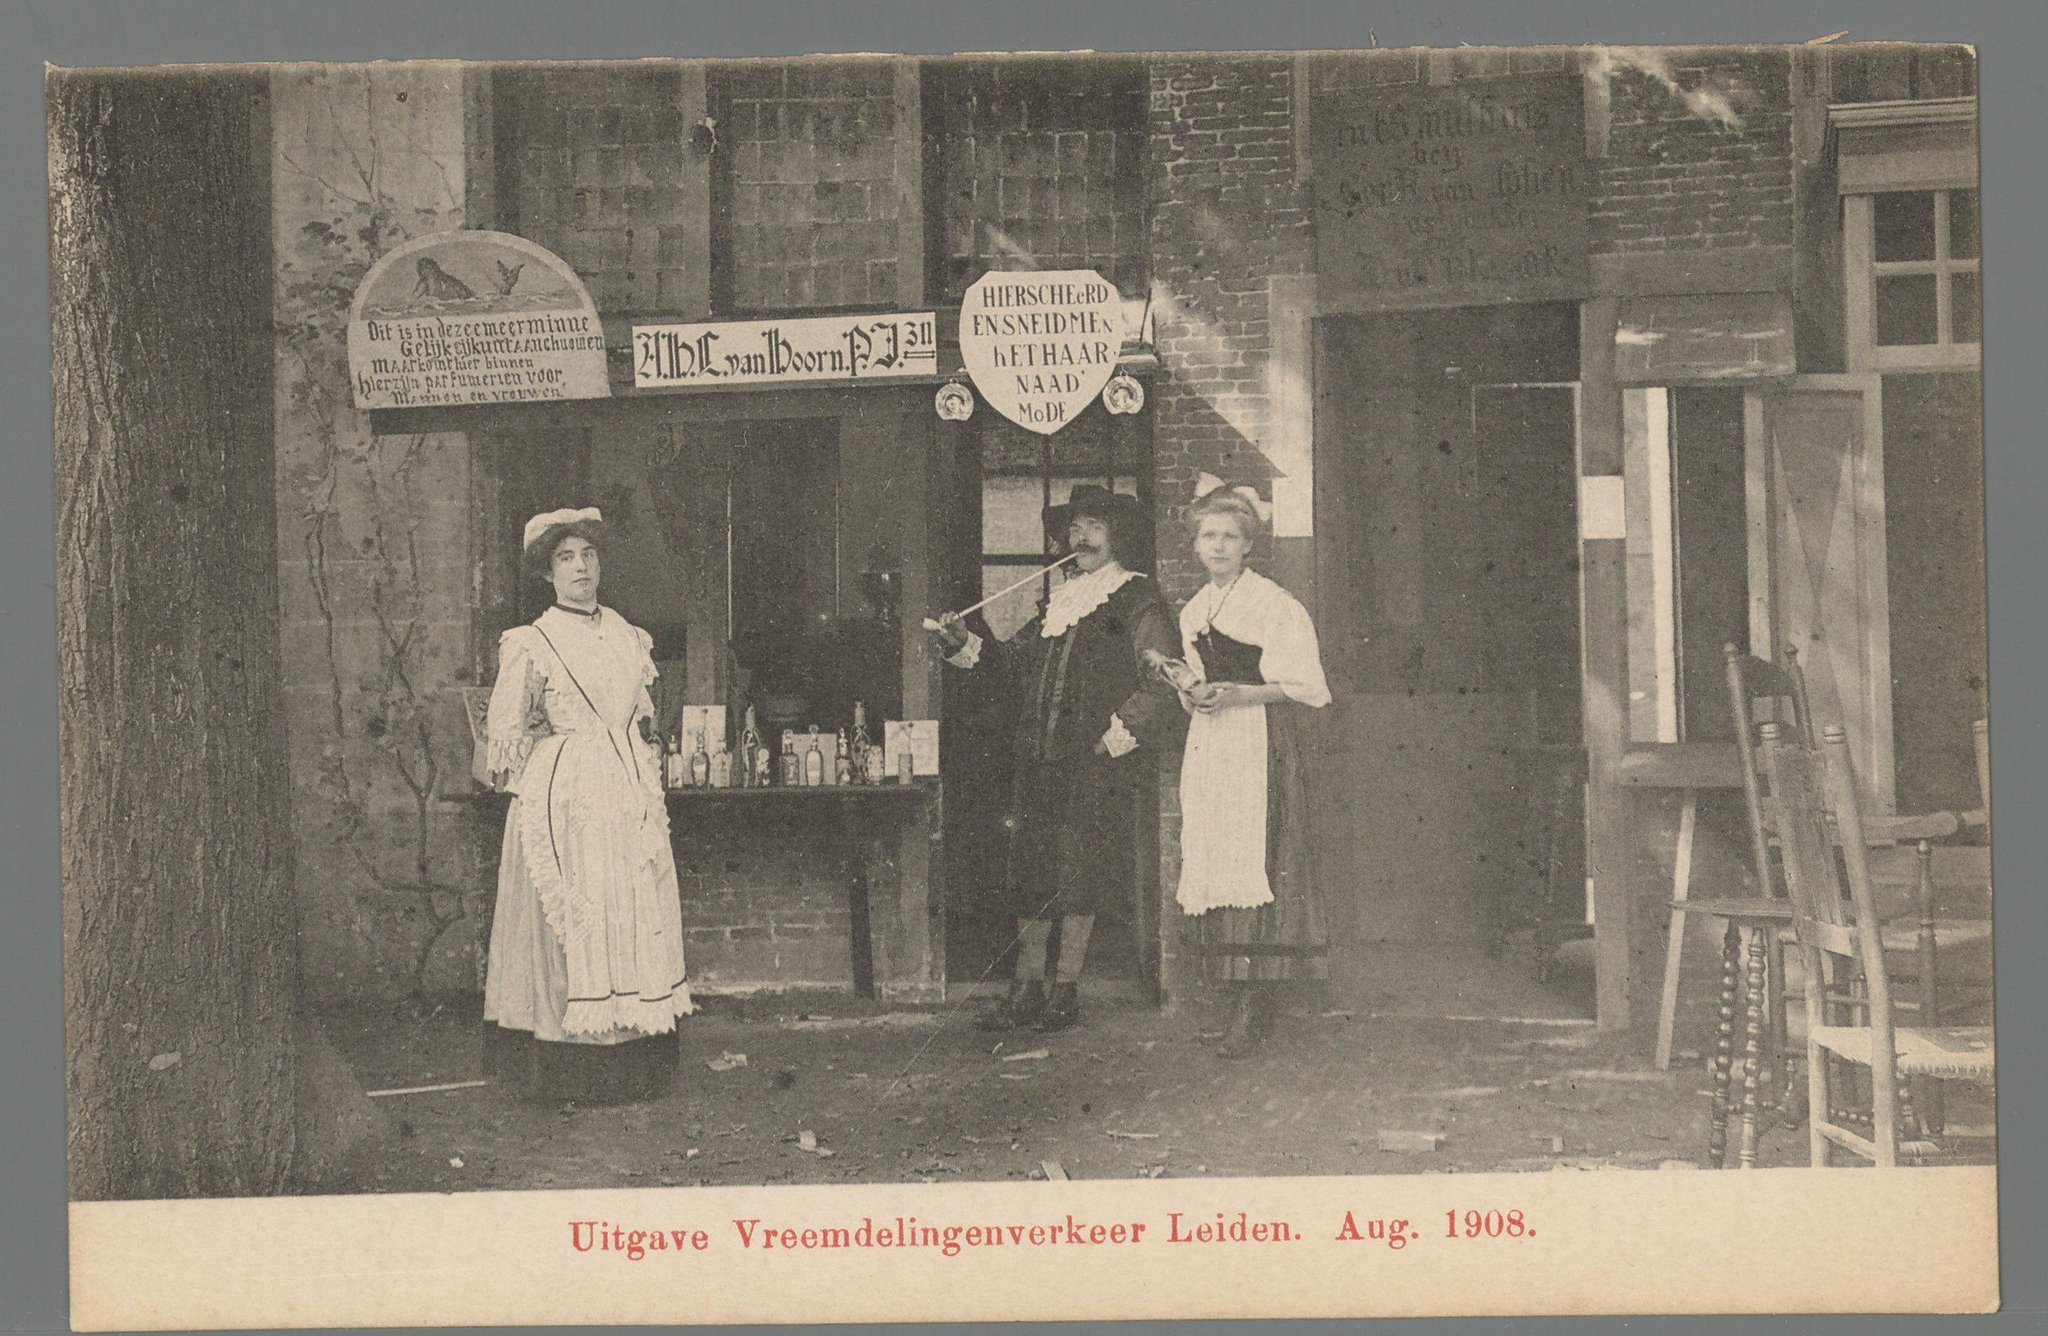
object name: photomechanical print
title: Mensen in kostuum voor een winkel tijdens de Oud-Hollandse feesten te Leiden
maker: Anonymous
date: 1908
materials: cardboard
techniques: photograph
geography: leiden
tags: shop, store, dress-up party, festivities, leiden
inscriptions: date